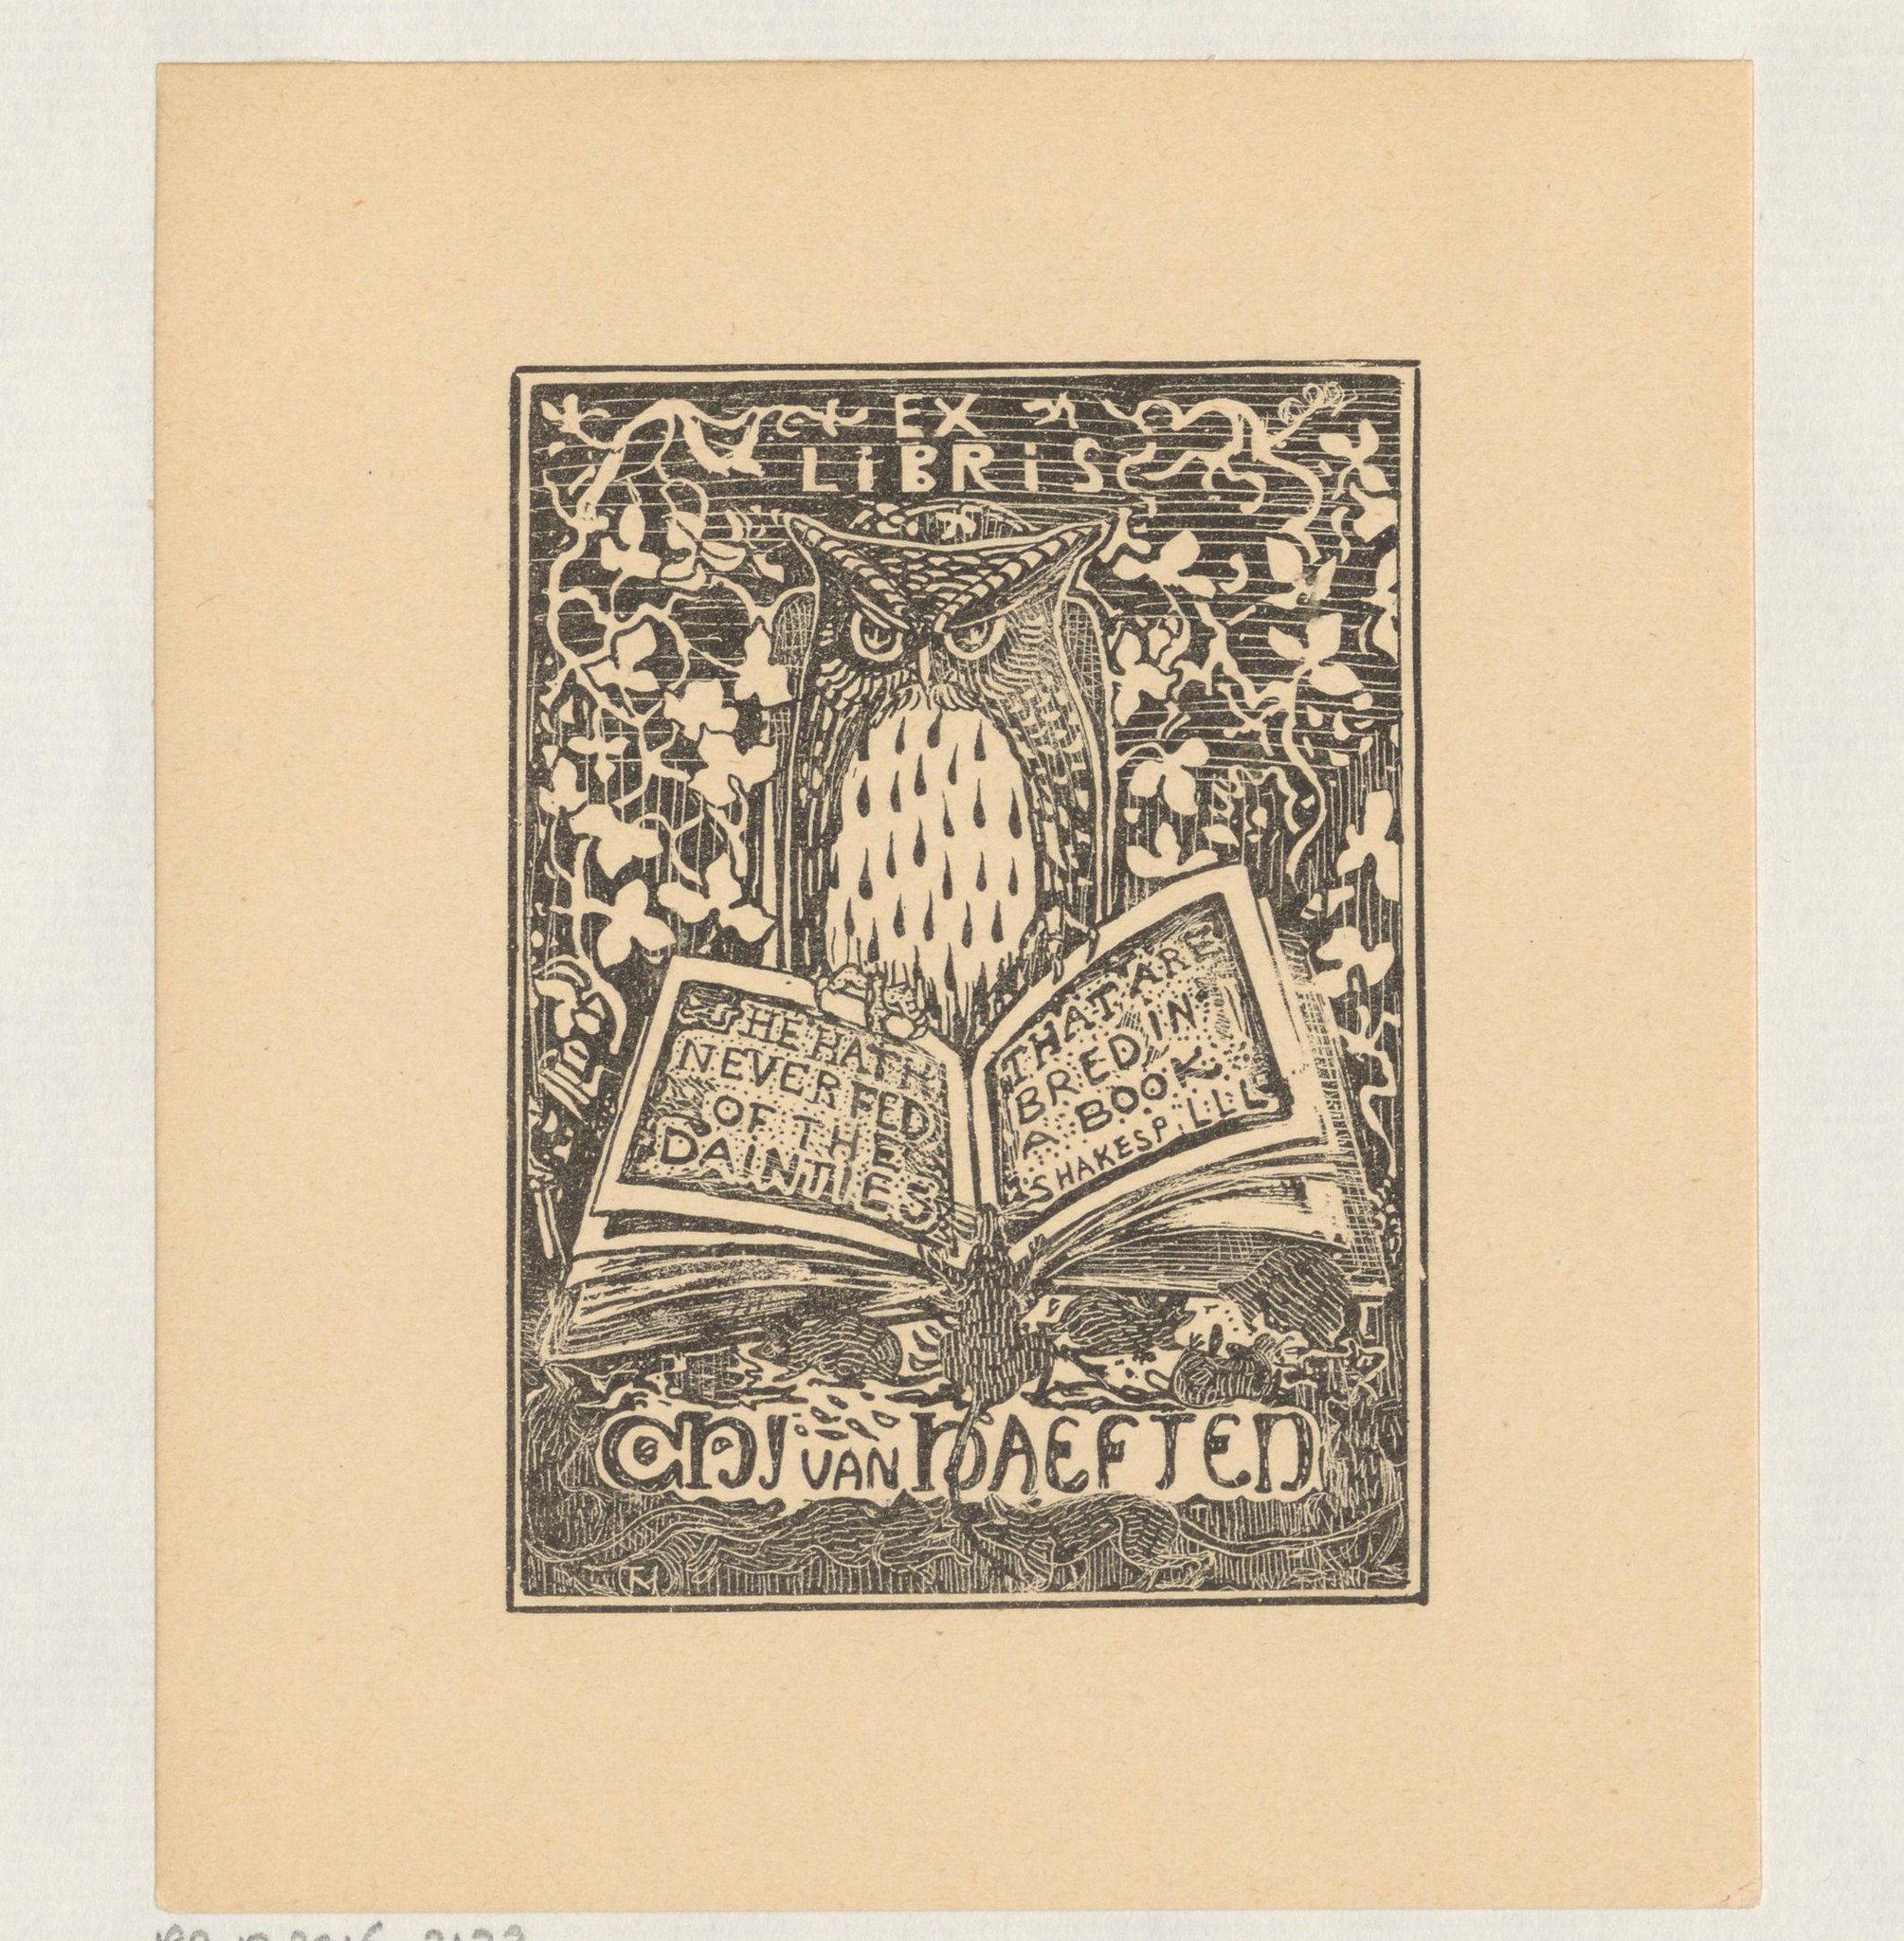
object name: bookplate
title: Ex libris van C.H.J. van Haeften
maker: theo van hoytema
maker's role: draughtsman, painter, print maker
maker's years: 1863-1917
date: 1894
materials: paper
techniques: lithograph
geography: netherlands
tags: william shakespeare, book, owls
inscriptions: inscription: ‘lithography Theo van Hoytema / ±1900’